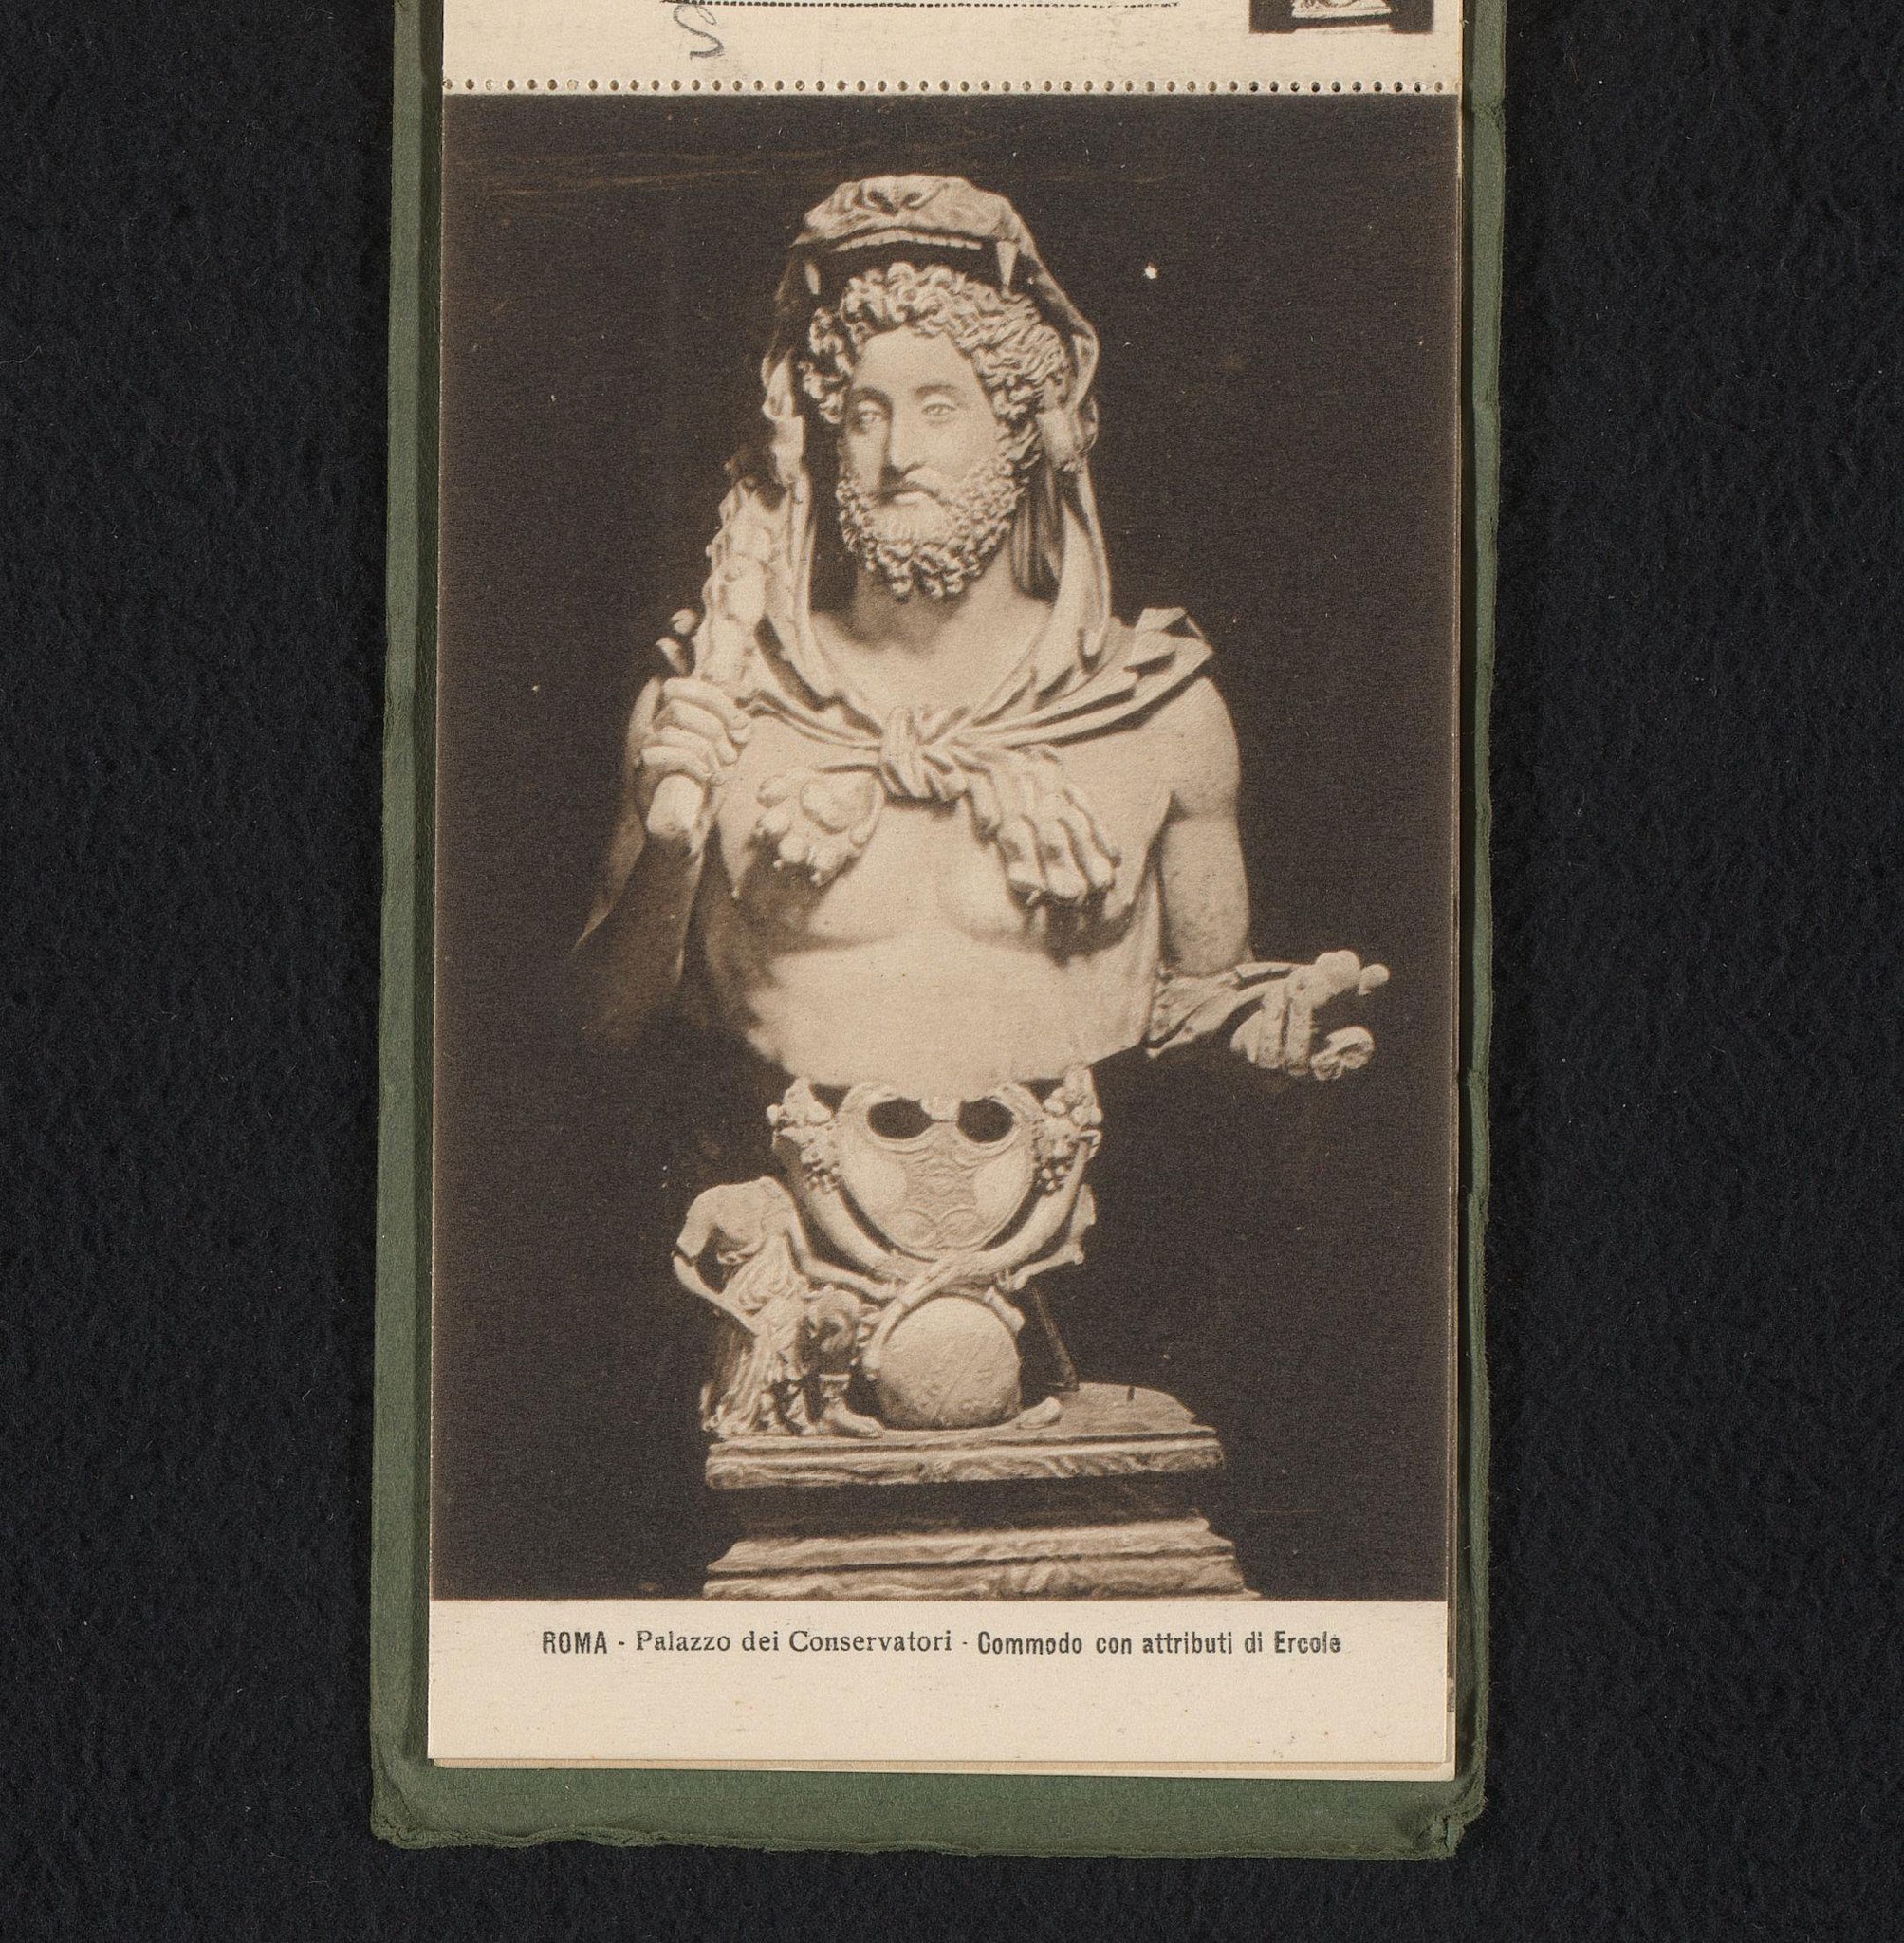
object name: ansichtkaart, prentbriefkaart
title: Roma - Palazzo dei Conservatori - Commodo con attributi di Ercole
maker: Anonymous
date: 1905-1930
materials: cardboard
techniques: photograph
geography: milan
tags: statues, paintings, etc. ~ objects of worship in roman religion, permanent exhibition, museum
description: Prentbriefkaart maakt deel uit van een album.